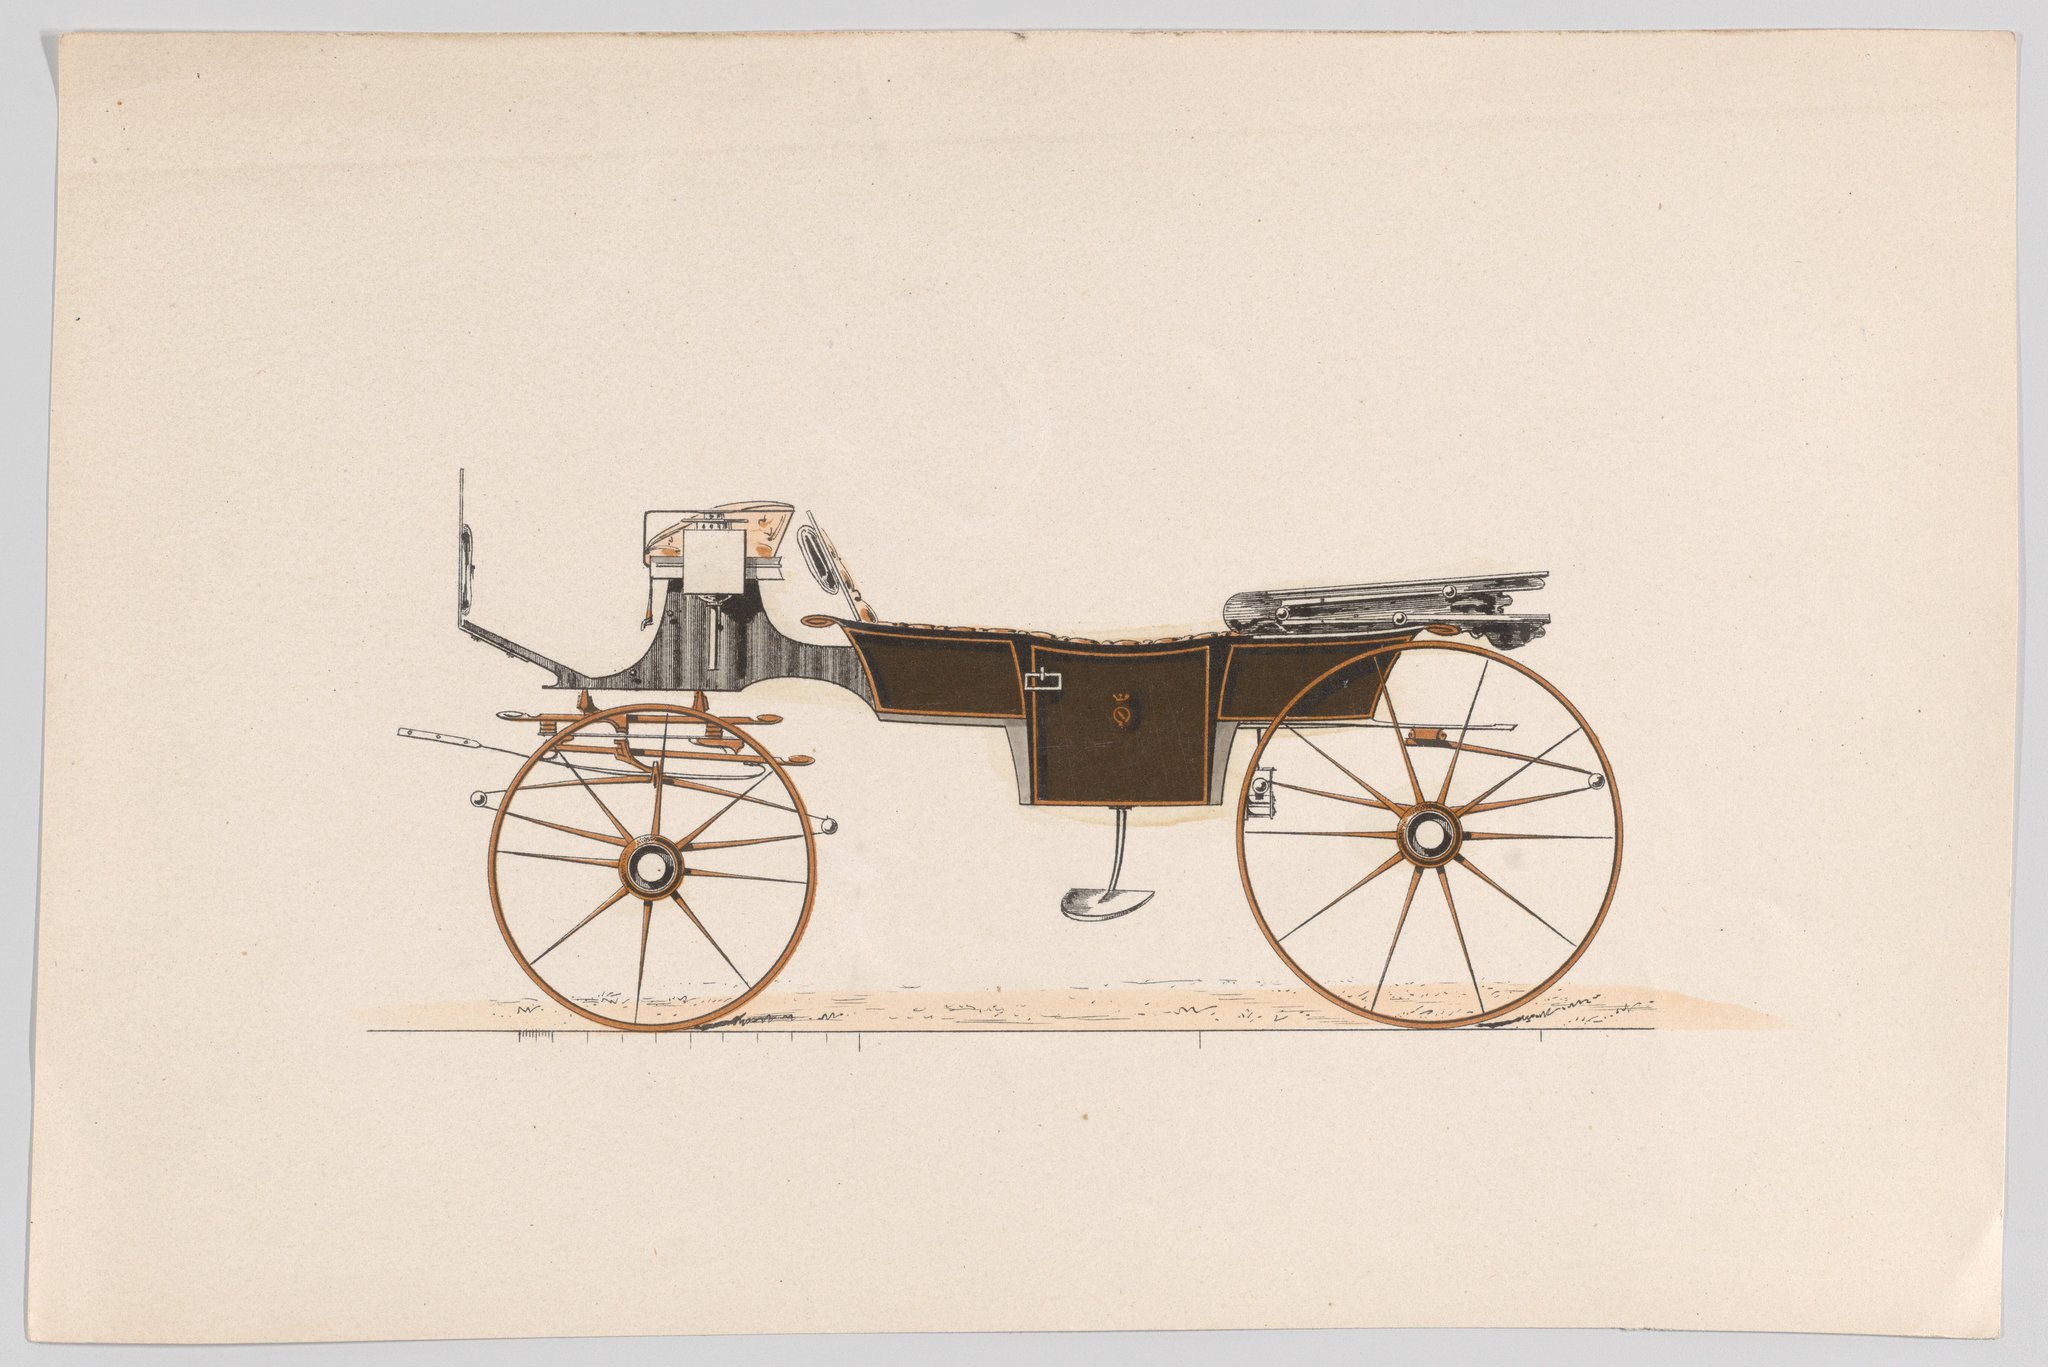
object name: print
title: Design for Vis-A-Vis/Sociable Carriage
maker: anonymous, french, 19th century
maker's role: artist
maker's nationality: french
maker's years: 1800-1900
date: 1870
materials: gum arabic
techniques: hand coloring, lithograph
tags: carriages